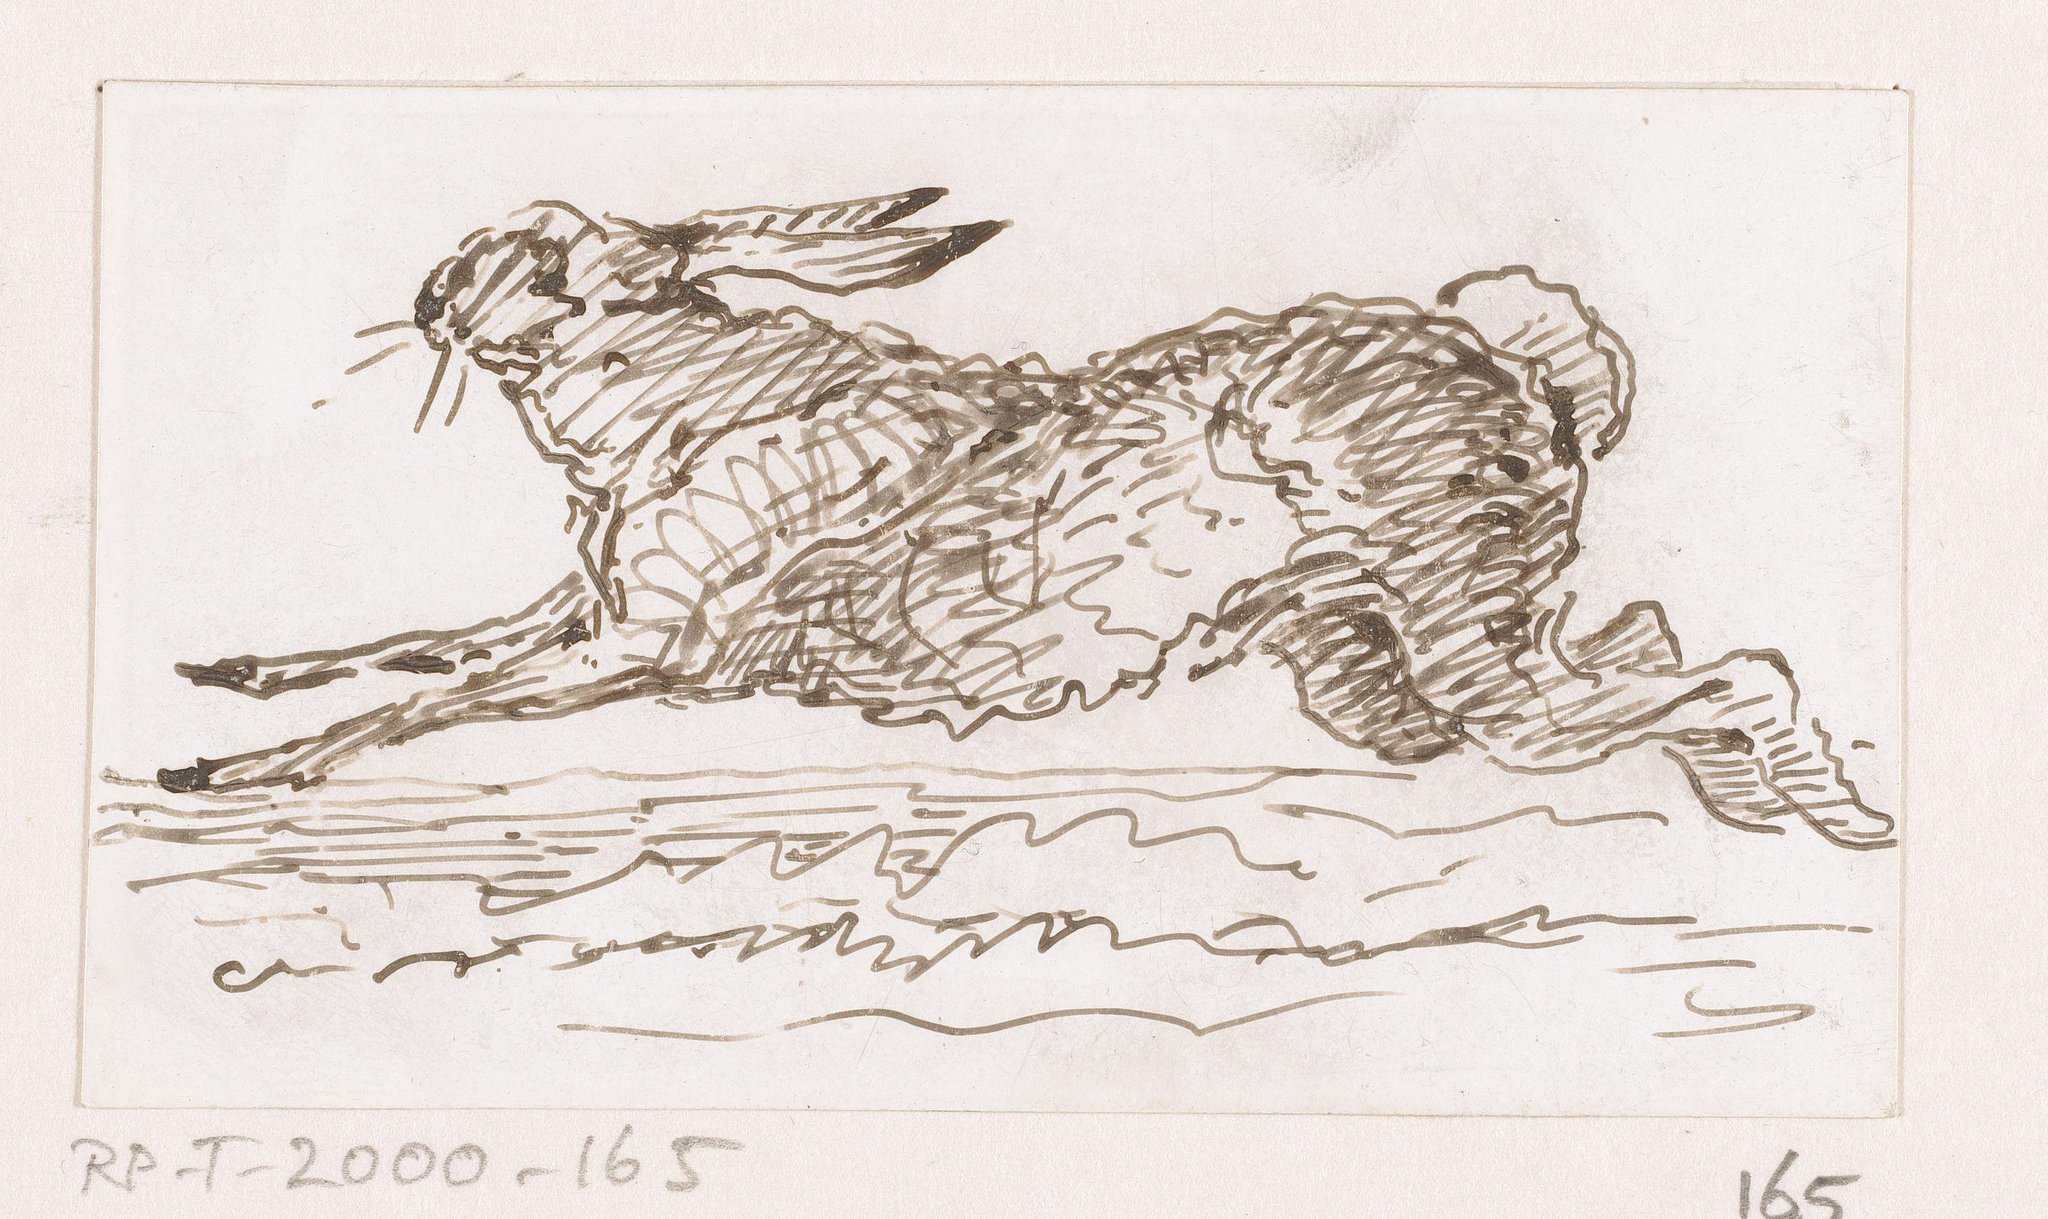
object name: visiting card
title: Haas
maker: johannes tavenraat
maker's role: draughtsman, painter, print maker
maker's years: 1809-1881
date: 1869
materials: ink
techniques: pen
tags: rodents: hare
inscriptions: collector's mark: Lugt 2228, signature and date: ‘Tav. 1/1 69’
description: Haas, hollend naar links, getekend op de keerzijde van het visitekaartje van: 'G. Coulander, en Echtgenoote'.